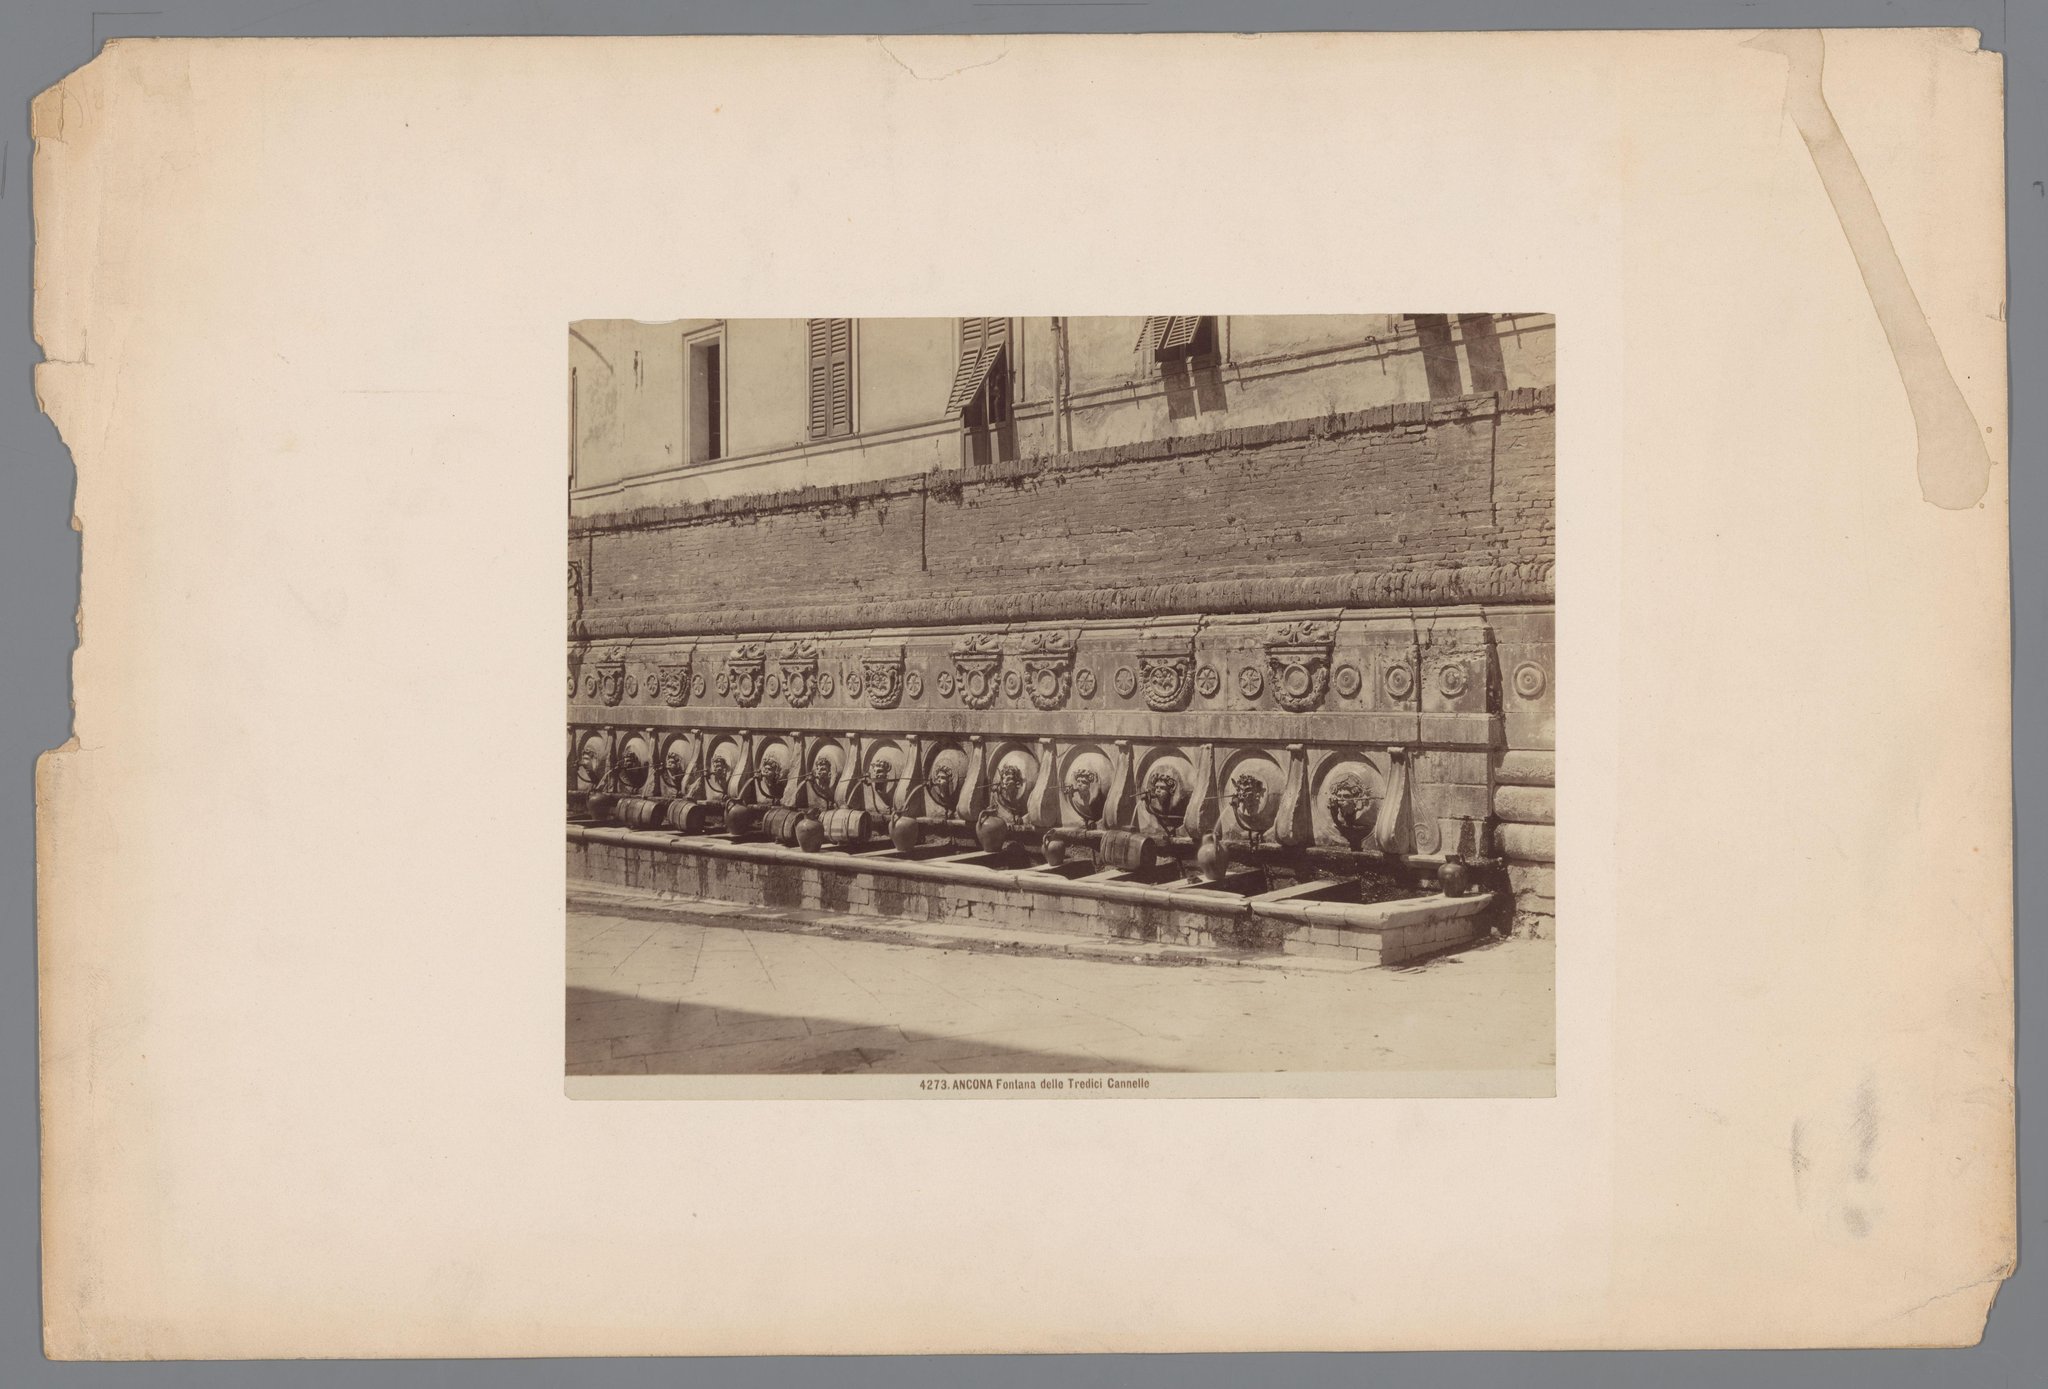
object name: photograph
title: ANCONA Fontana delle Tredici Cannelle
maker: Anonymous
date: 1875-1900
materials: cardboard, photographic support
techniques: albumen print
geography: ancona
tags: ornamental fountain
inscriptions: collector's mark: Lugt 3937, number: ‘4273.’